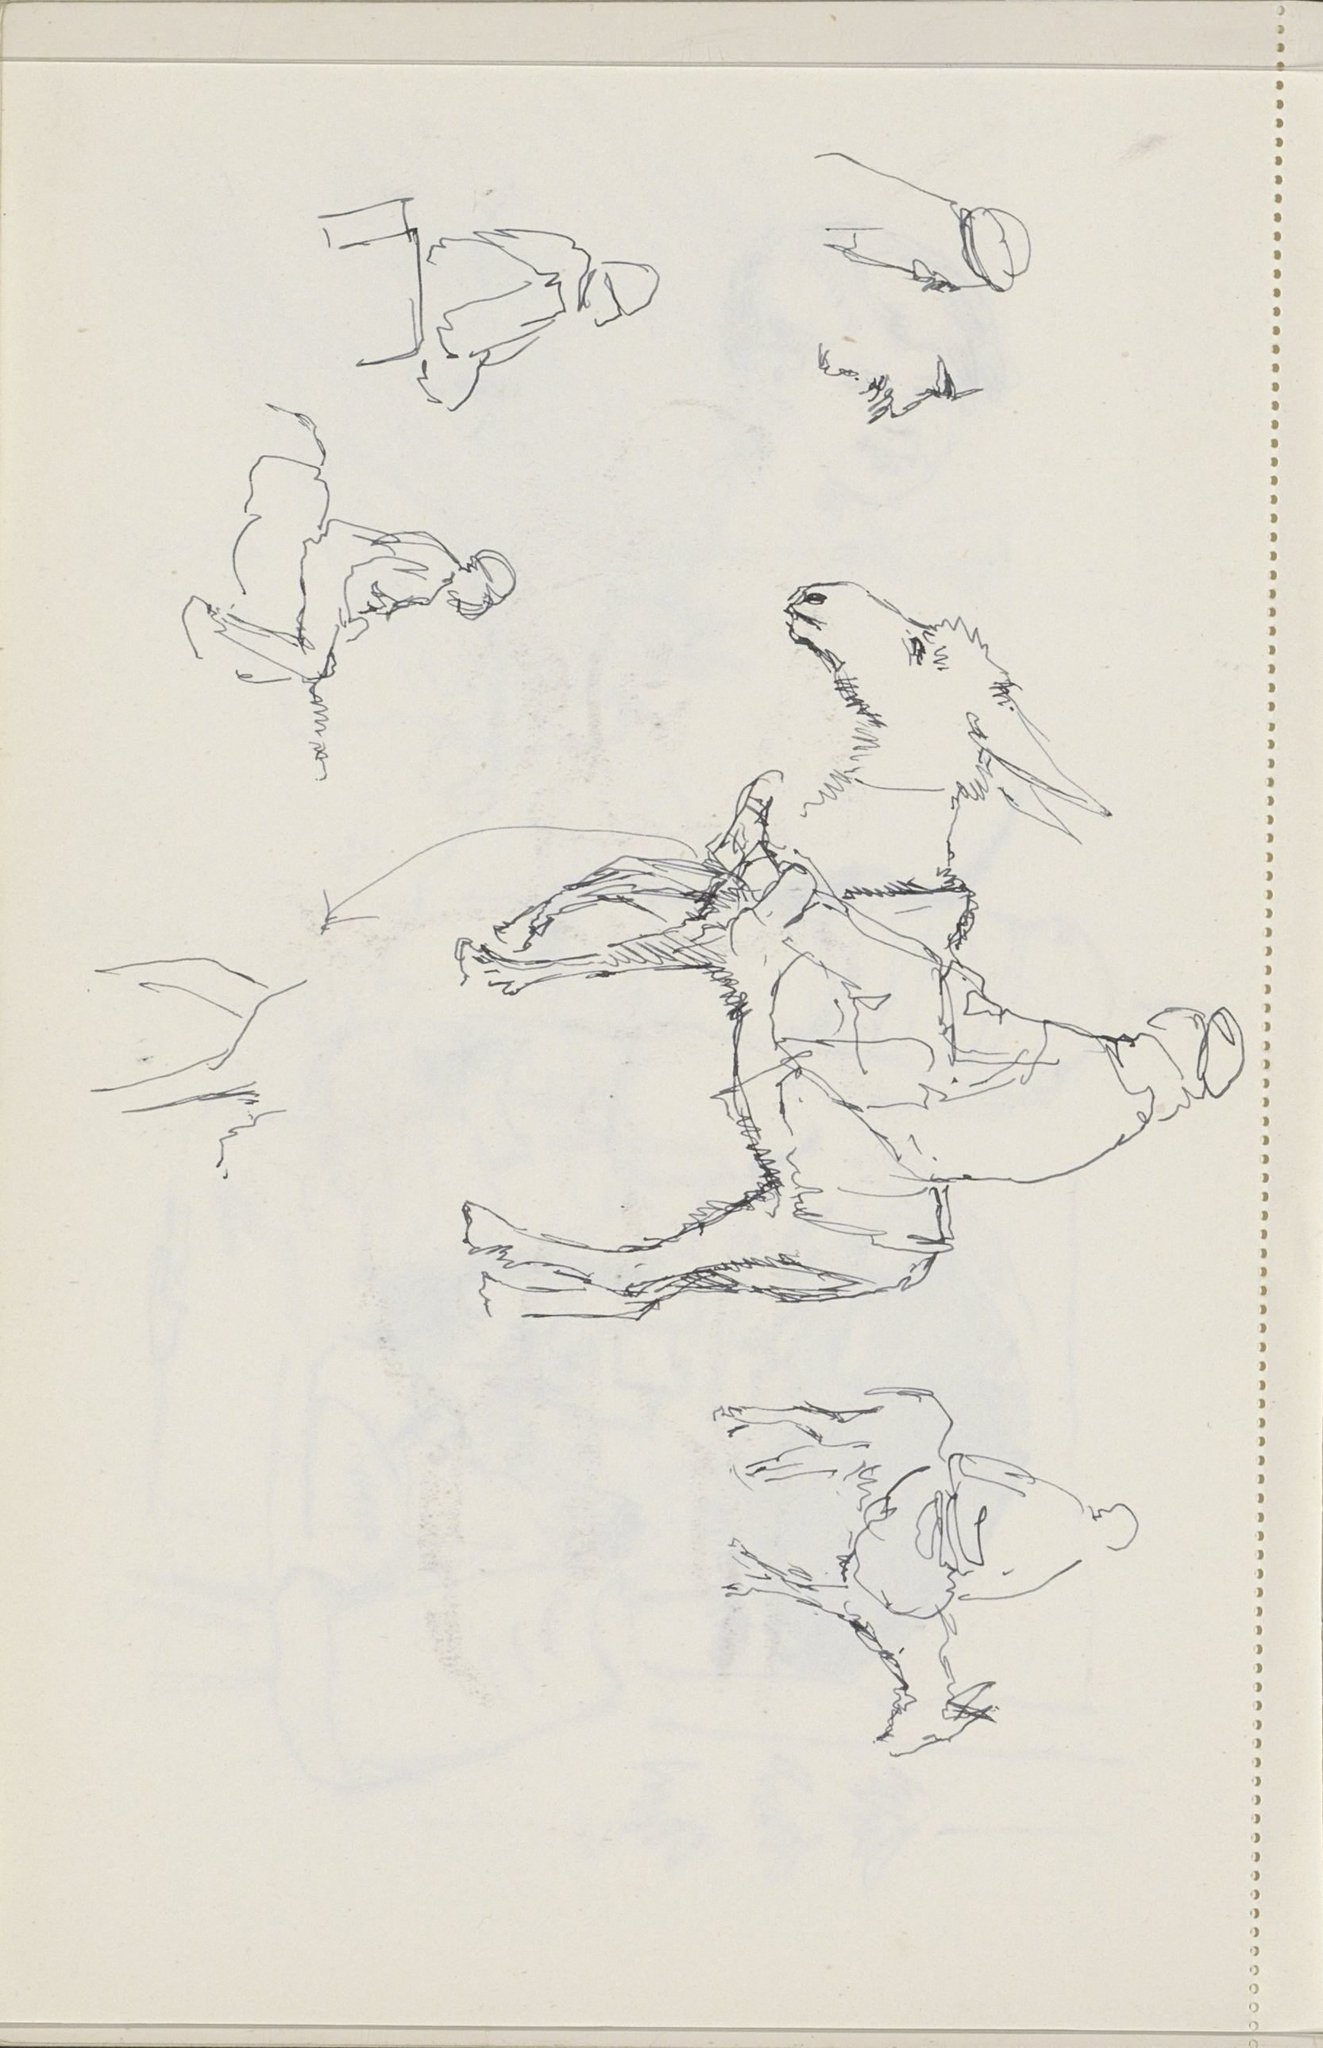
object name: sketchbook leaf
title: Man in oosters kostuum op een ezel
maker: cornelis vreedenburgh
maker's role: draughtsman, print maker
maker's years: 1880-1946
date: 1936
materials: ink, paper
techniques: pen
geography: maghreb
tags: riding a horse, ass, or mule; rider, horseman, folk costume, regional costume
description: Tevens studies van een man in oosters kostuum. Blad 50 verso uit een schetsboek met 73 bladen.